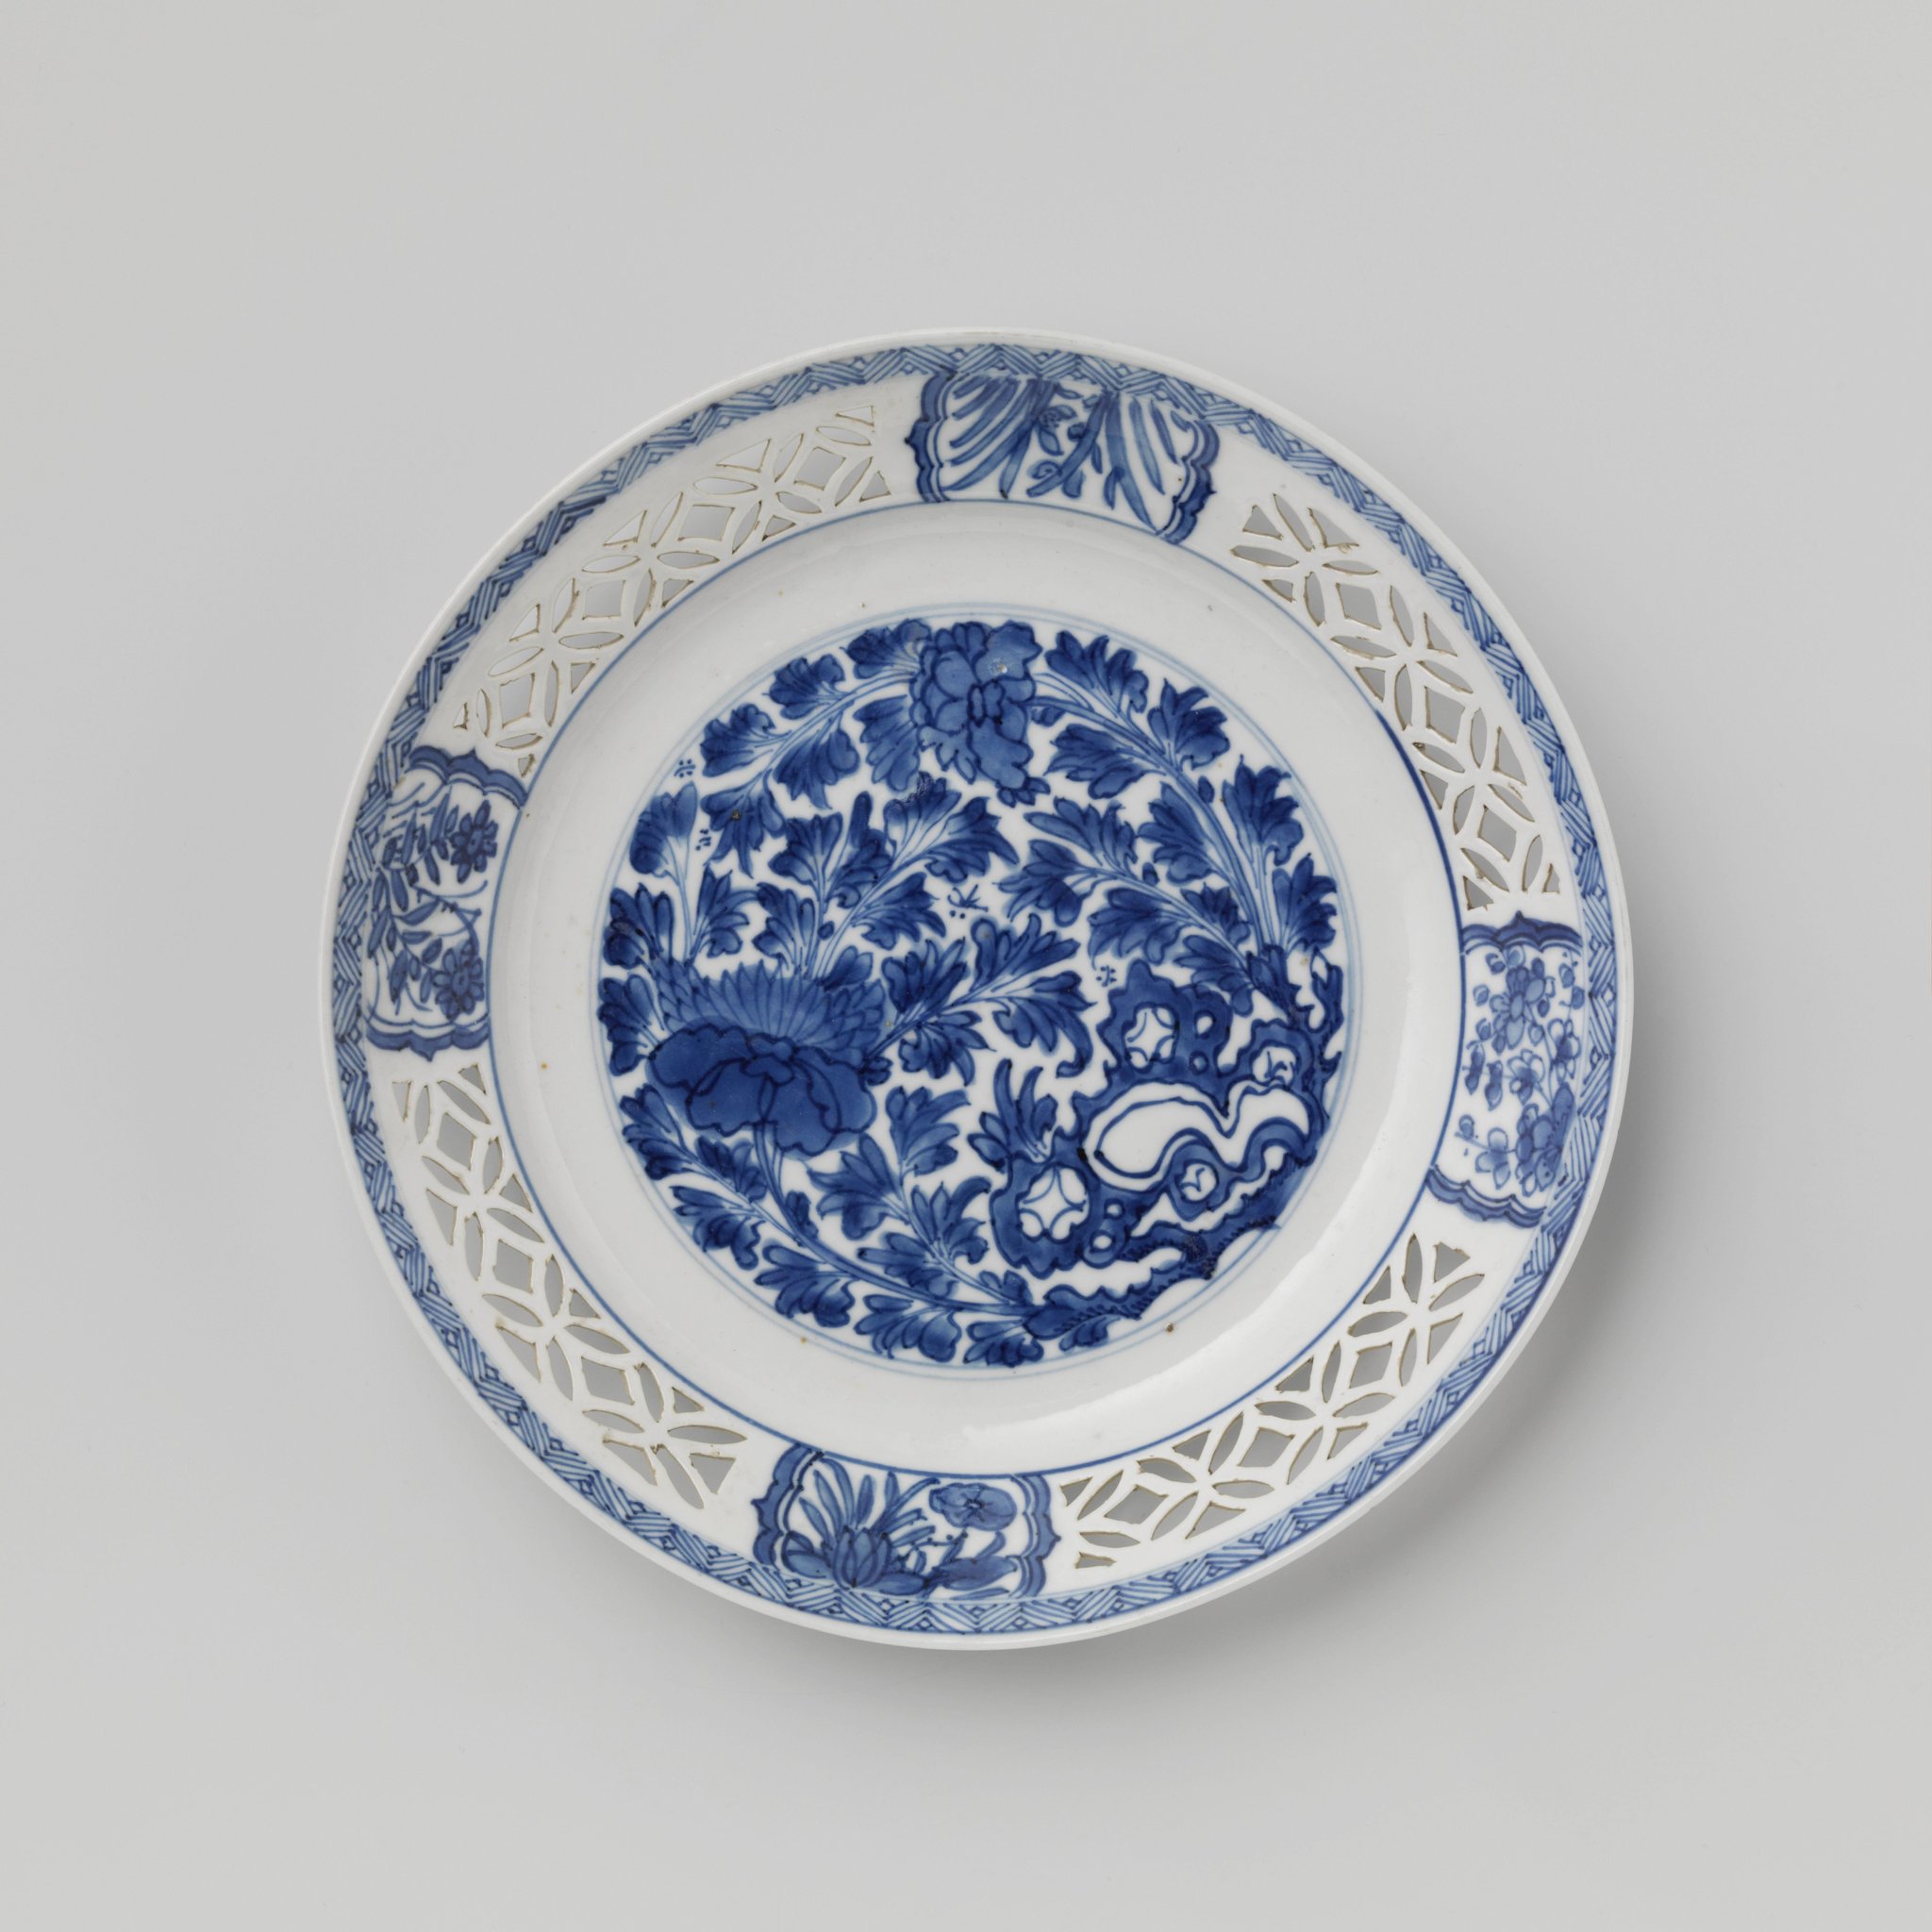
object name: plate dish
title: Plate with flowering plants near a rock and pierced rim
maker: Anonymous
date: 1725-1749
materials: cobalt, glaze, paint, porcelain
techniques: embroidery, firing, turning, vitrification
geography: china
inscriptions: mark